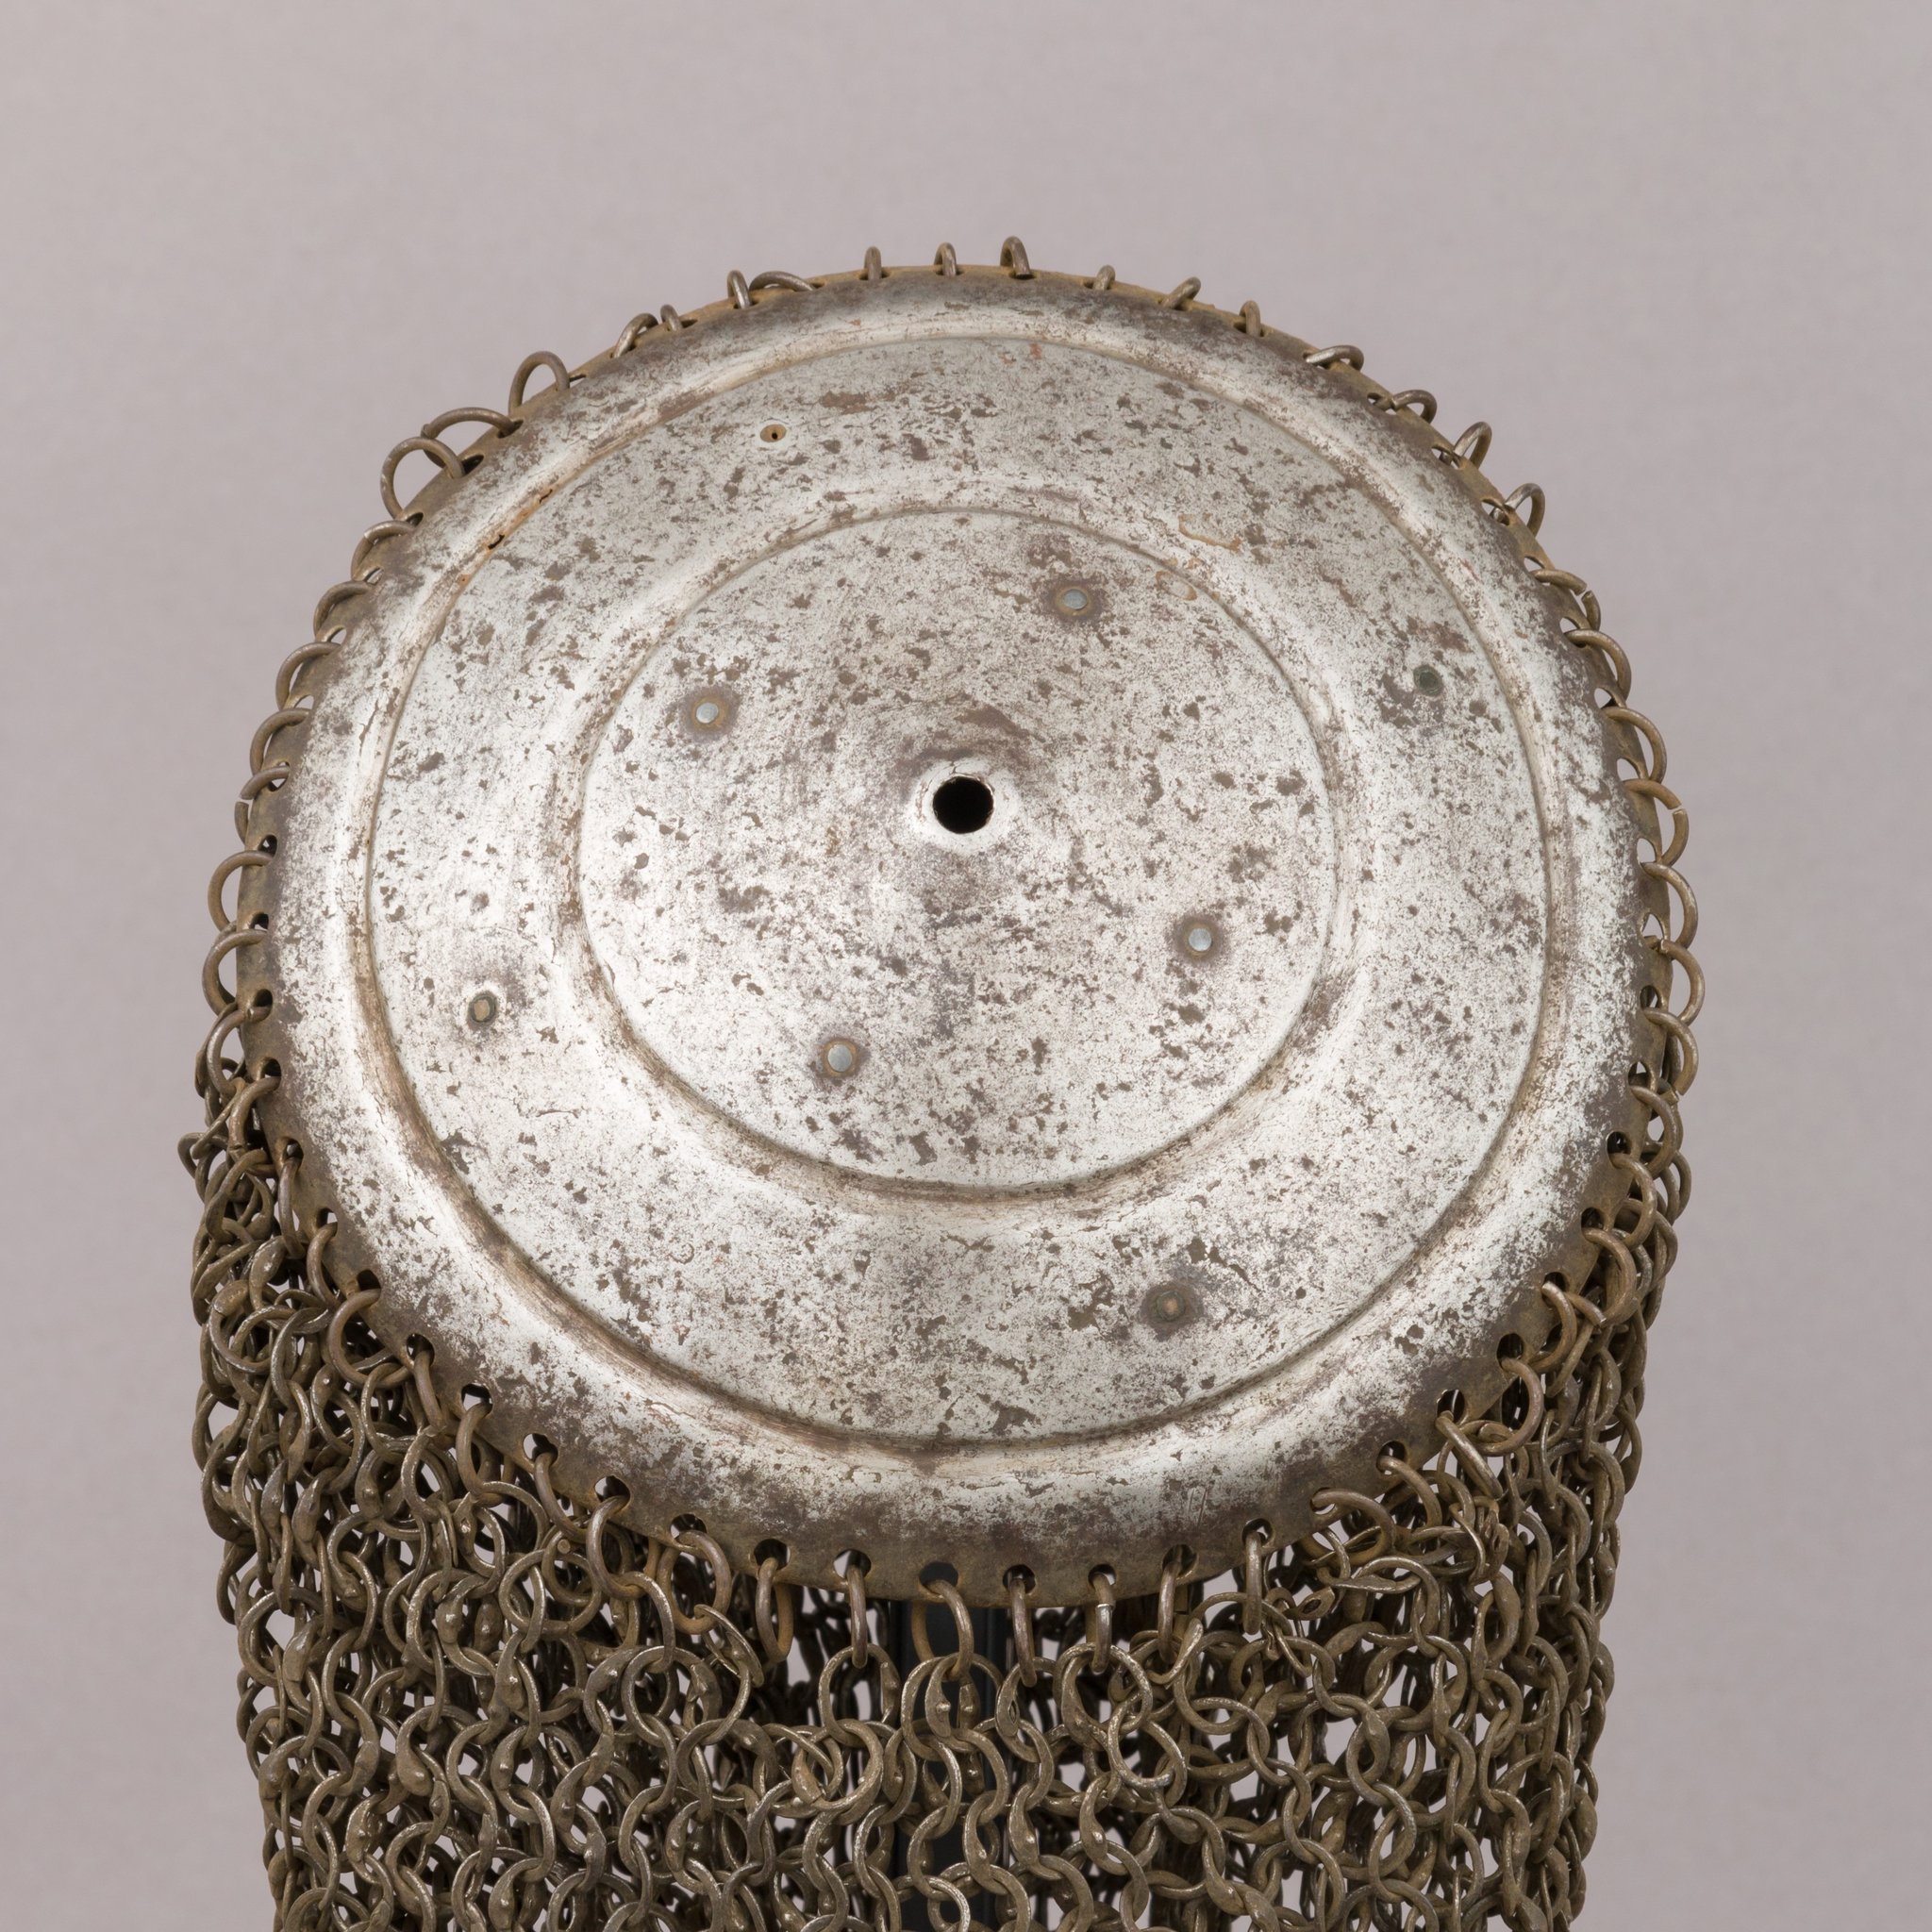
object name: helmet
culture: caucasian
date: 1701-1900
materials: steel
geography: caucasus